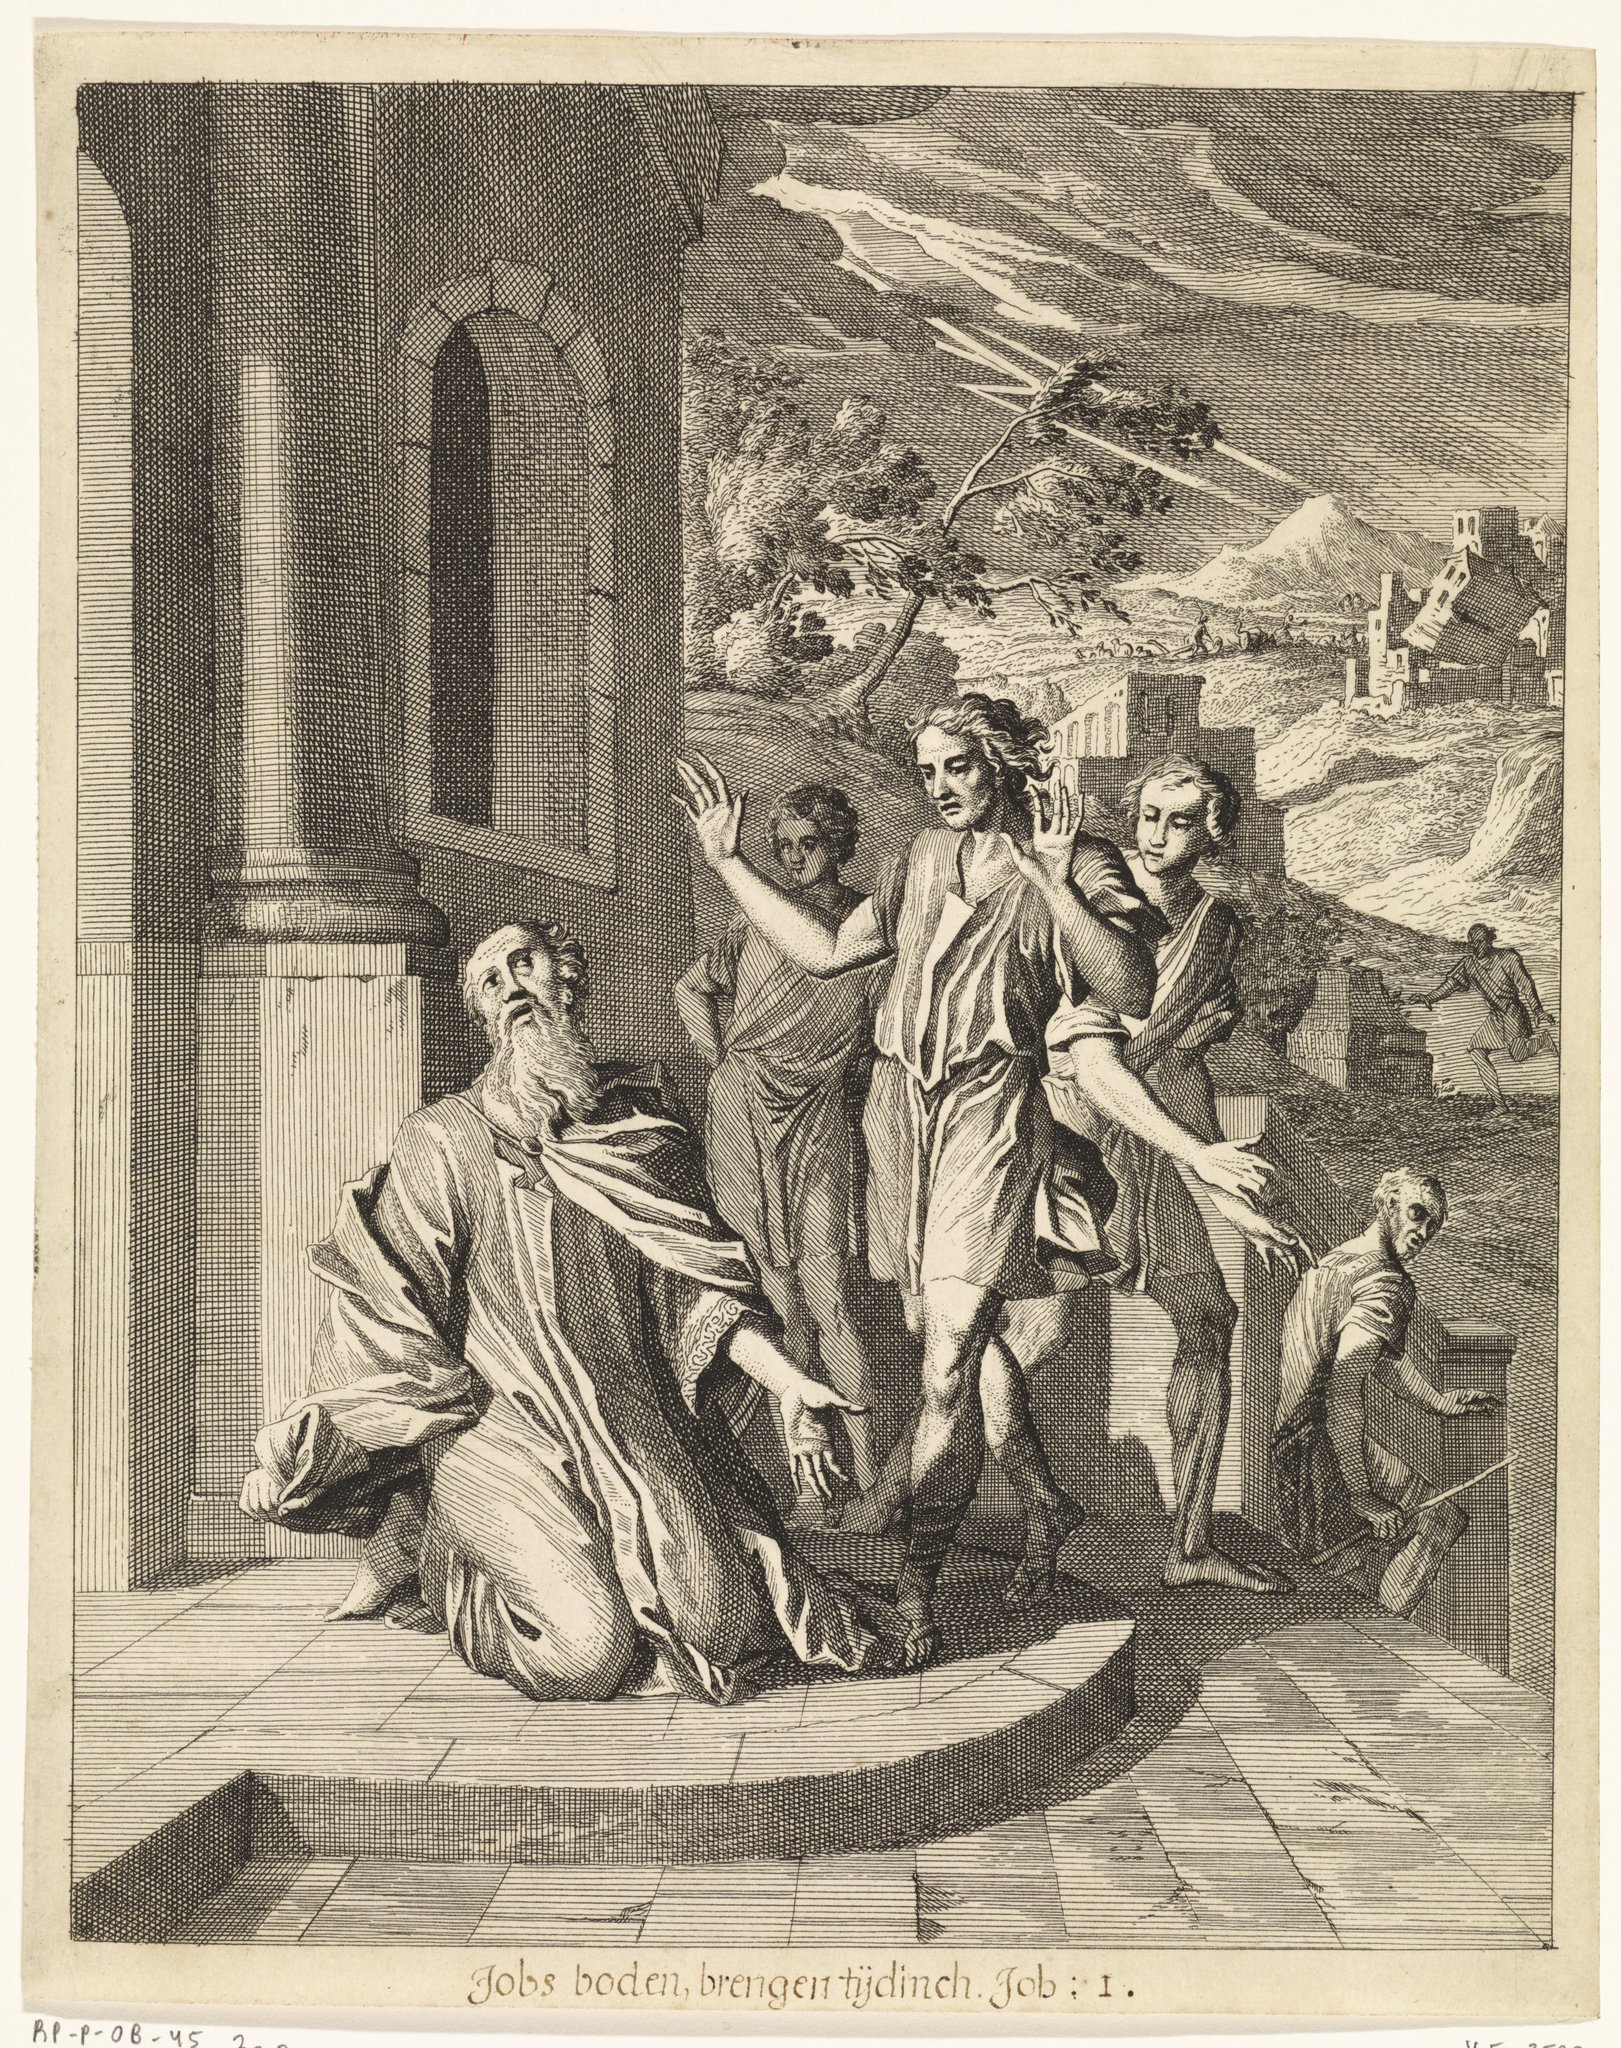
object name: print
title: Job ontvangt het slechte nieuws van vier boodschappers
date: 1708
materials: paper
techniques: etching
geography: nuremberg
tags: messengers present themselves to job, each reporting a new disaster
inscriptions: collector's mark: Lugt 2228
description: Proefdruk van een prent welke is opgenomen als illustratie in: Historiae Celebriores Veteris Testamenti. Christoph Weigel, 1708.